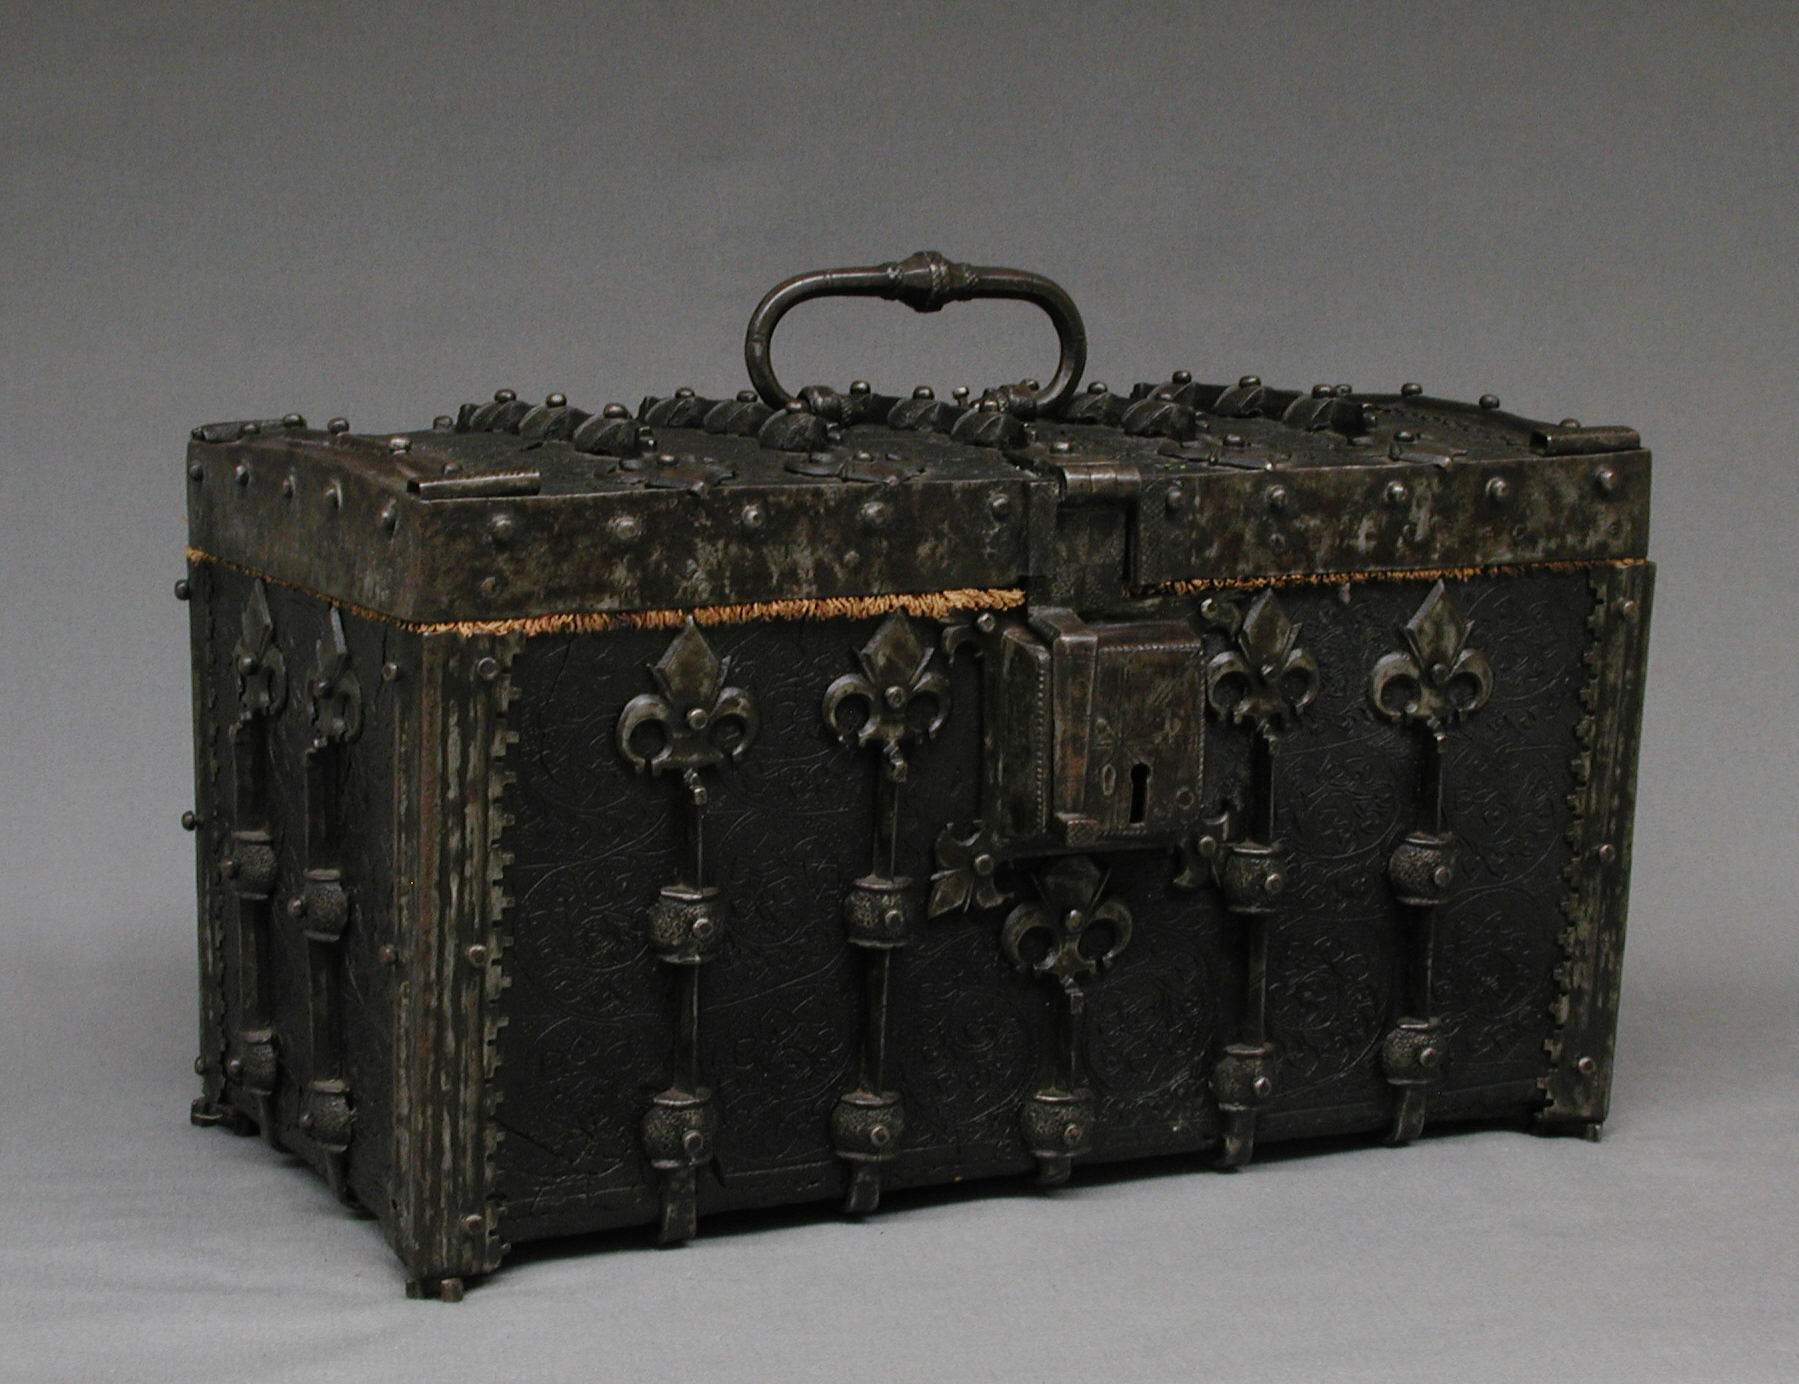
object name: coffer with key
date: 1501-1600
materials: iron, leather, wood